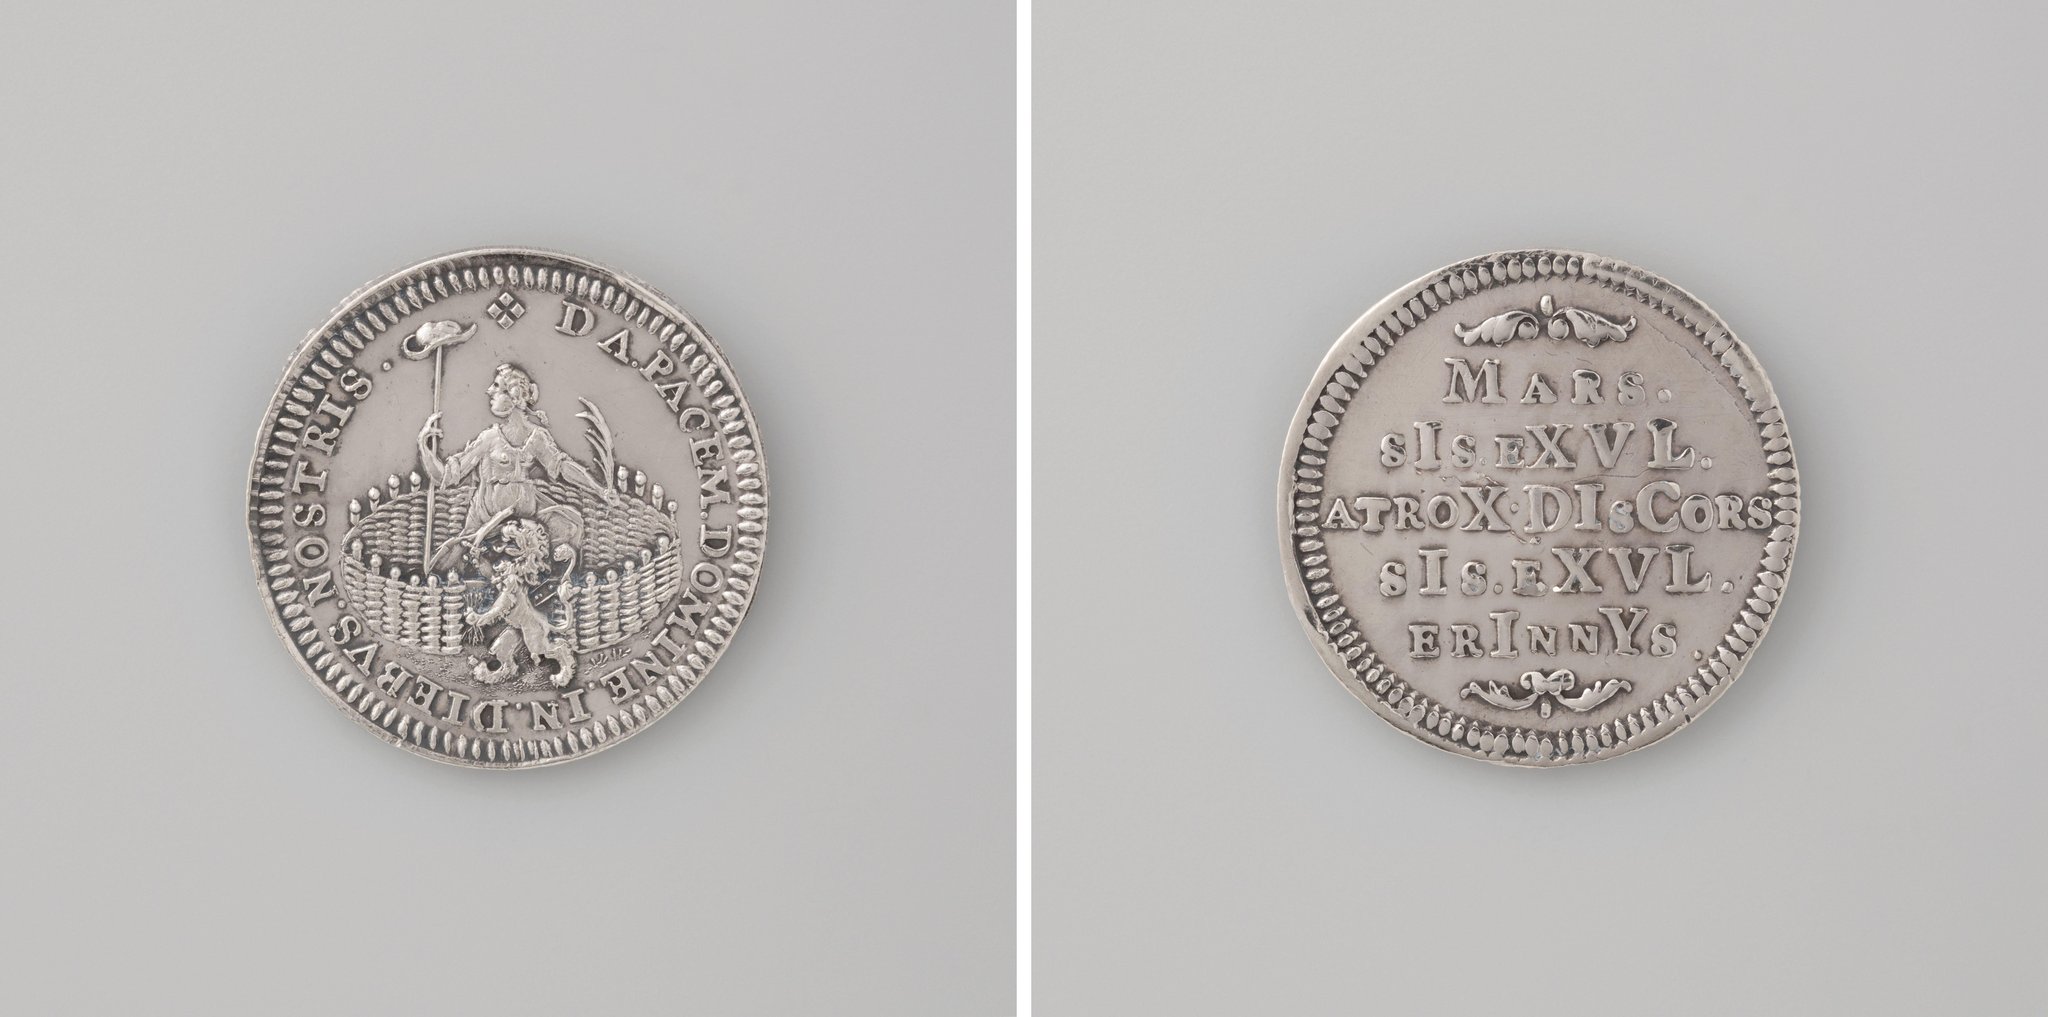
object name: new year medal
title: Aanvang van het jaar 1749, op de vrede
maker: Anonymous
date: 1748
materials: silver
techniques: striking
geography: netherlands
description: Zilveren penning. Voorzijde: Nederland, in gedaante van vrouw met vrijheidshoed op speer en palmtak in een gesloten tuin, waarvoor leeuw met getrokken zwaard en pijlenbundel waakt binnen omschrift. Keerzijde: opschrift tussen bladermotieven